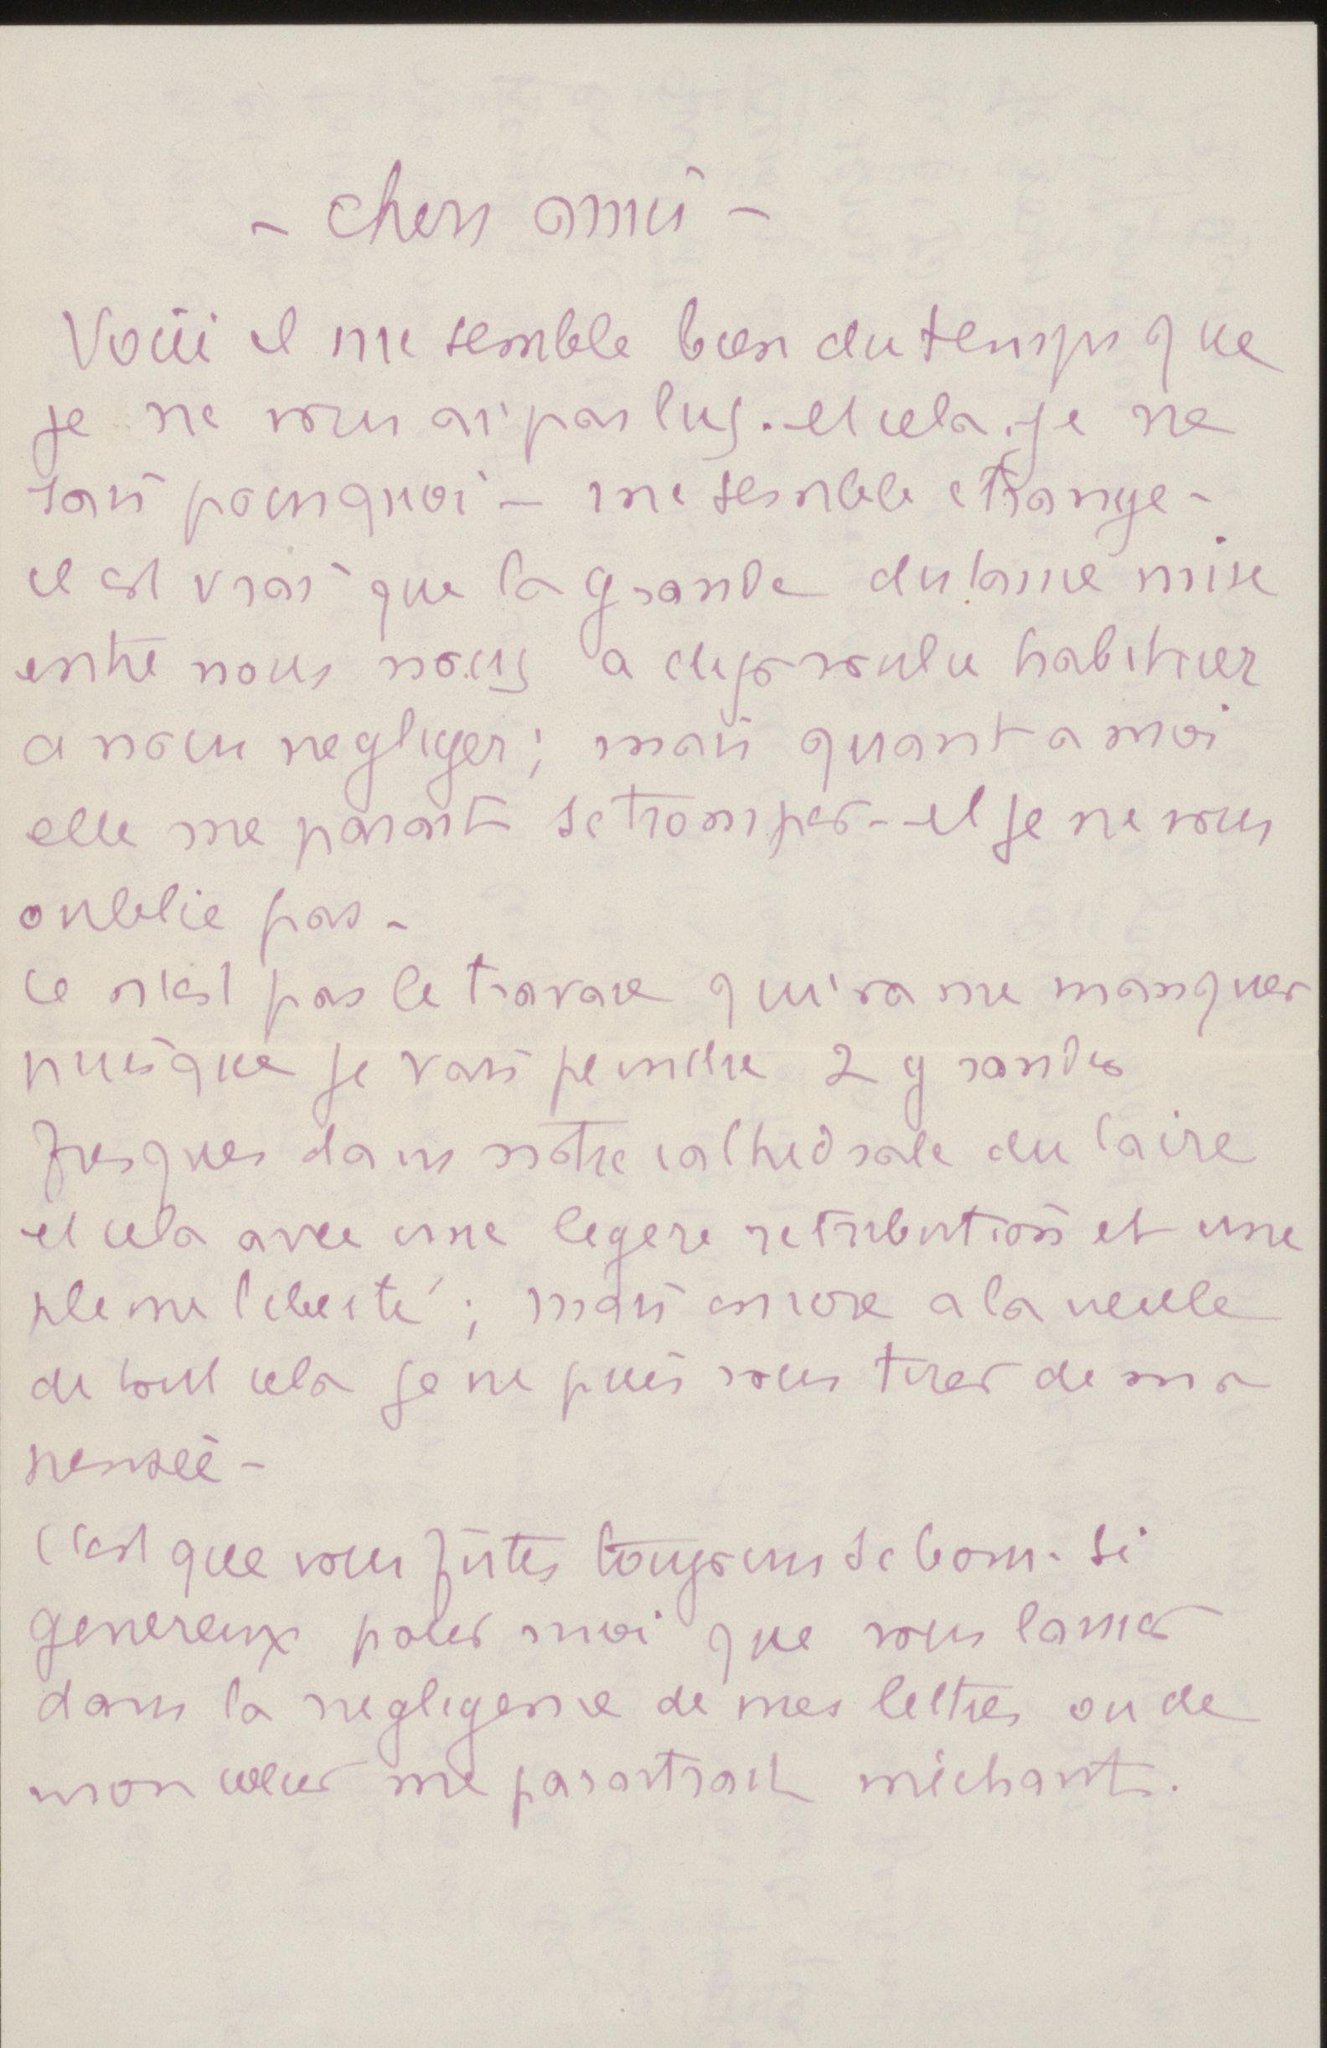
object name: letter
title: Brief aan Andries Bonger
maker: émile bernard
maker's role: print maker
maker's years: 1868-1941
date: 1812-1895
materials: ink, paper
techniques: pen, writing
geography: cairo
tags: paris, painter, print maker, draughtsman, vincent van gogh, amsterdam, andries bonger, drawing, passions, emotions, affections, family life, money, italy